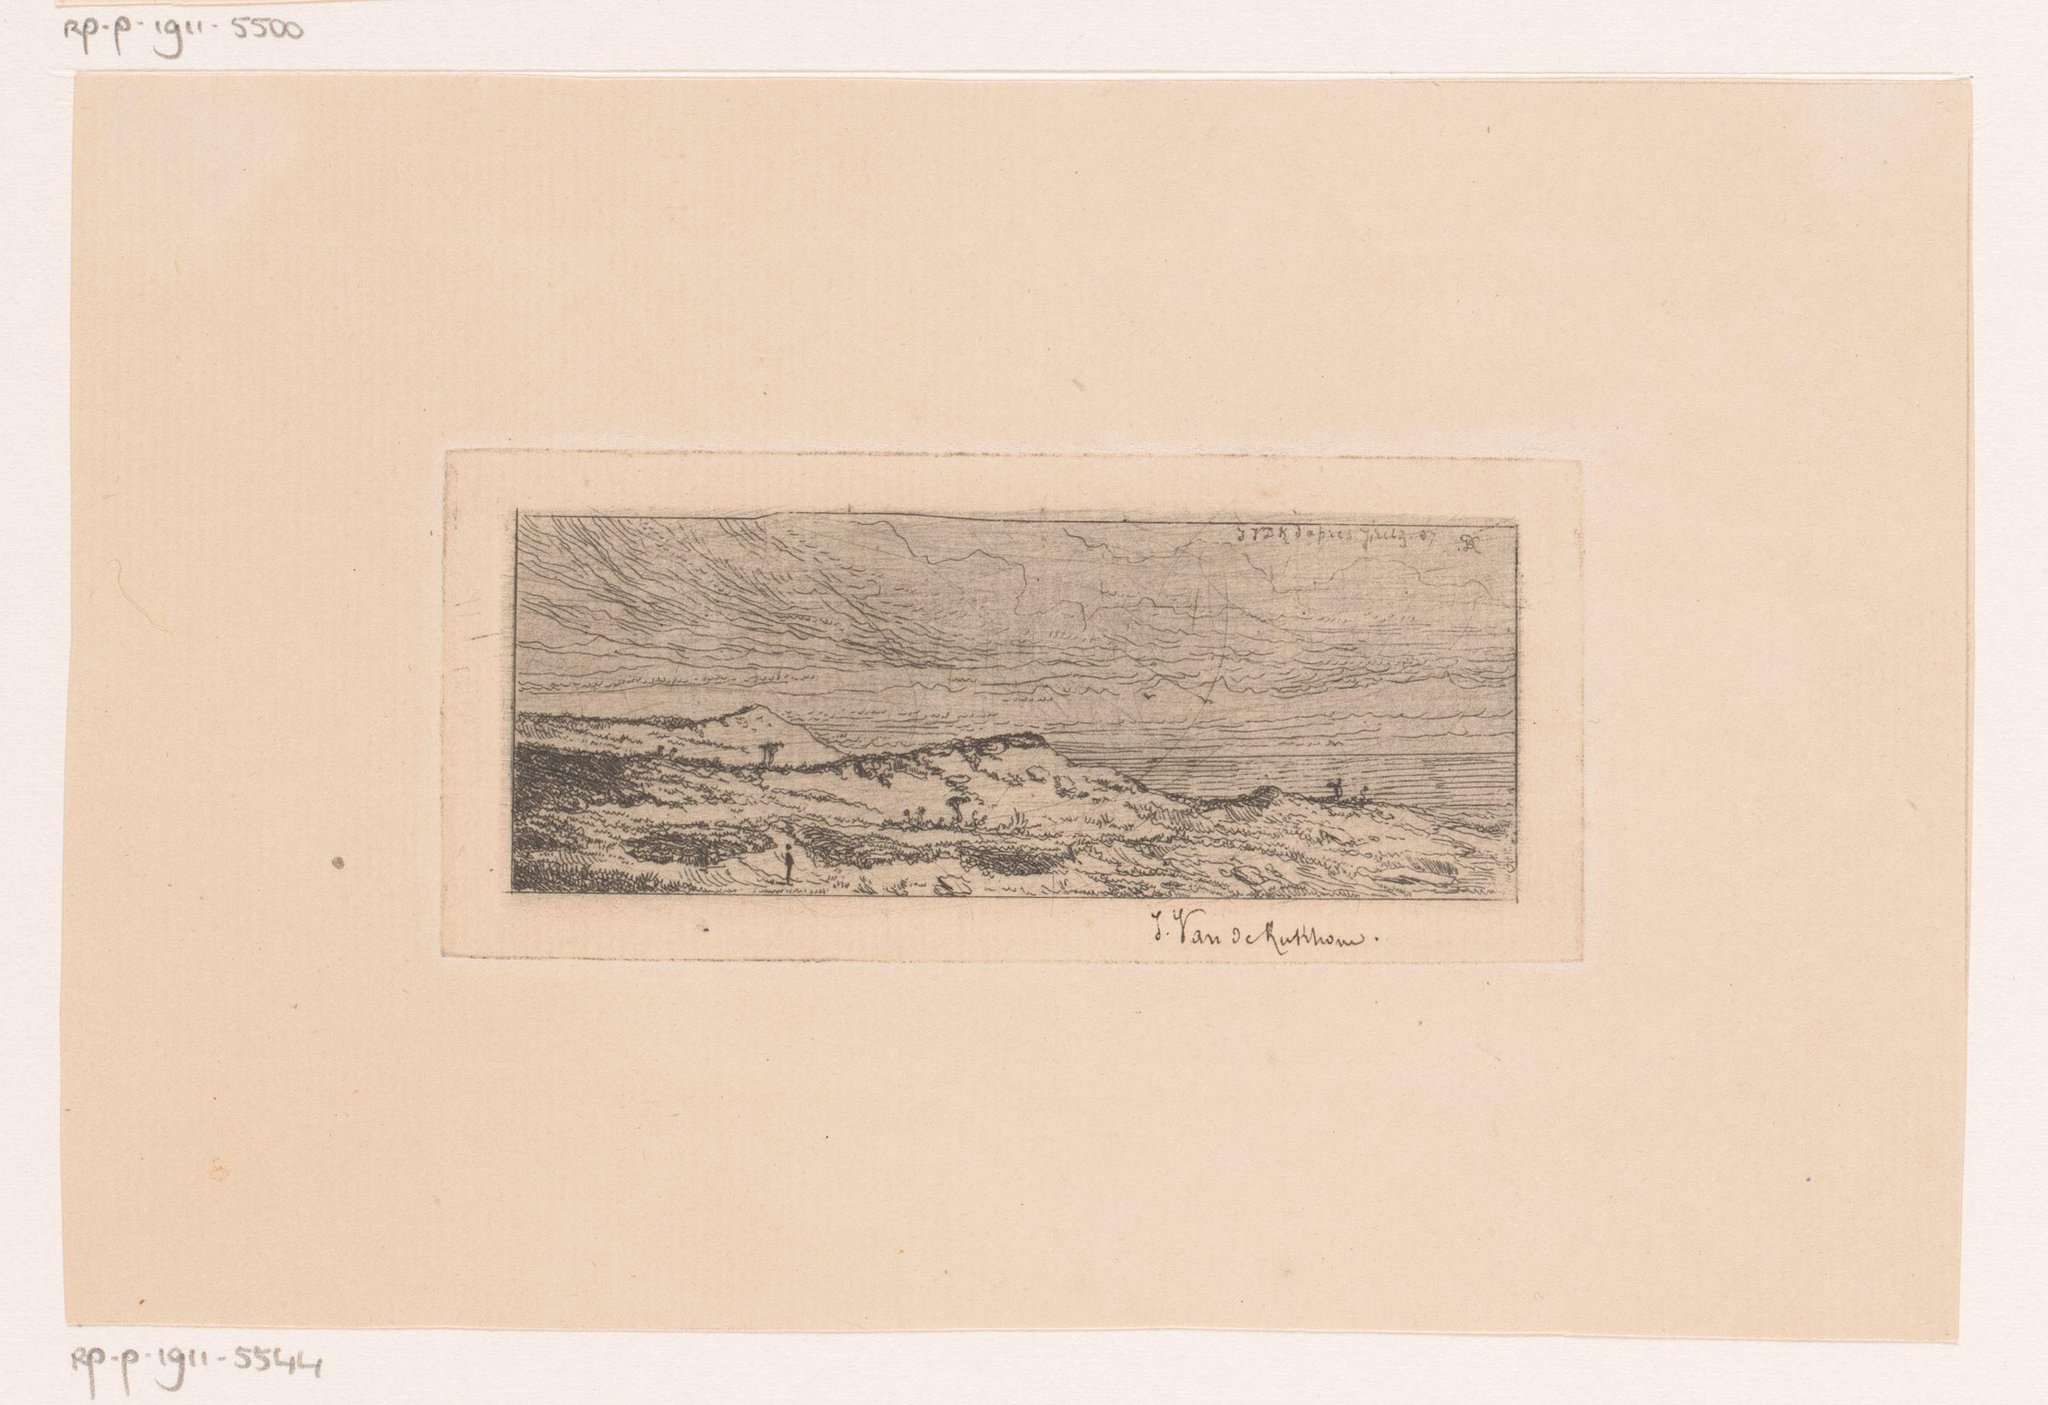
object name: print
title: Duinlandschap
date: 1877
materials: paper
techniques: etching, intaglio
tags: dune coast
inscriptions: collector's mark: Lugt 2228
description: De etsen naar de schilderijen van Frédéric Van de Kerkhove werden na zijn dood door zijn vader en zuster gemaakt en uitgegeven in twee reeksen. De eerste werd in 1877 uitgegeven door het Journal des Beaux-Arts et de la Littérature: Cahier de 25 Eaux-fortes d'après Frédéric van de Kerkhove, gravées par son père et sa sœur. De tweede reeks van 126 etsen, ook in 1877, werd in Parijs uitgegeven bij A. Lévy onder de titel Cent eaux-fortes gravées par J. Van de Kerkhove d'après les tableaux de Frédéric Van de Kerkhove, mort en 1873 à l'âge de 10 ans et 11 mois.